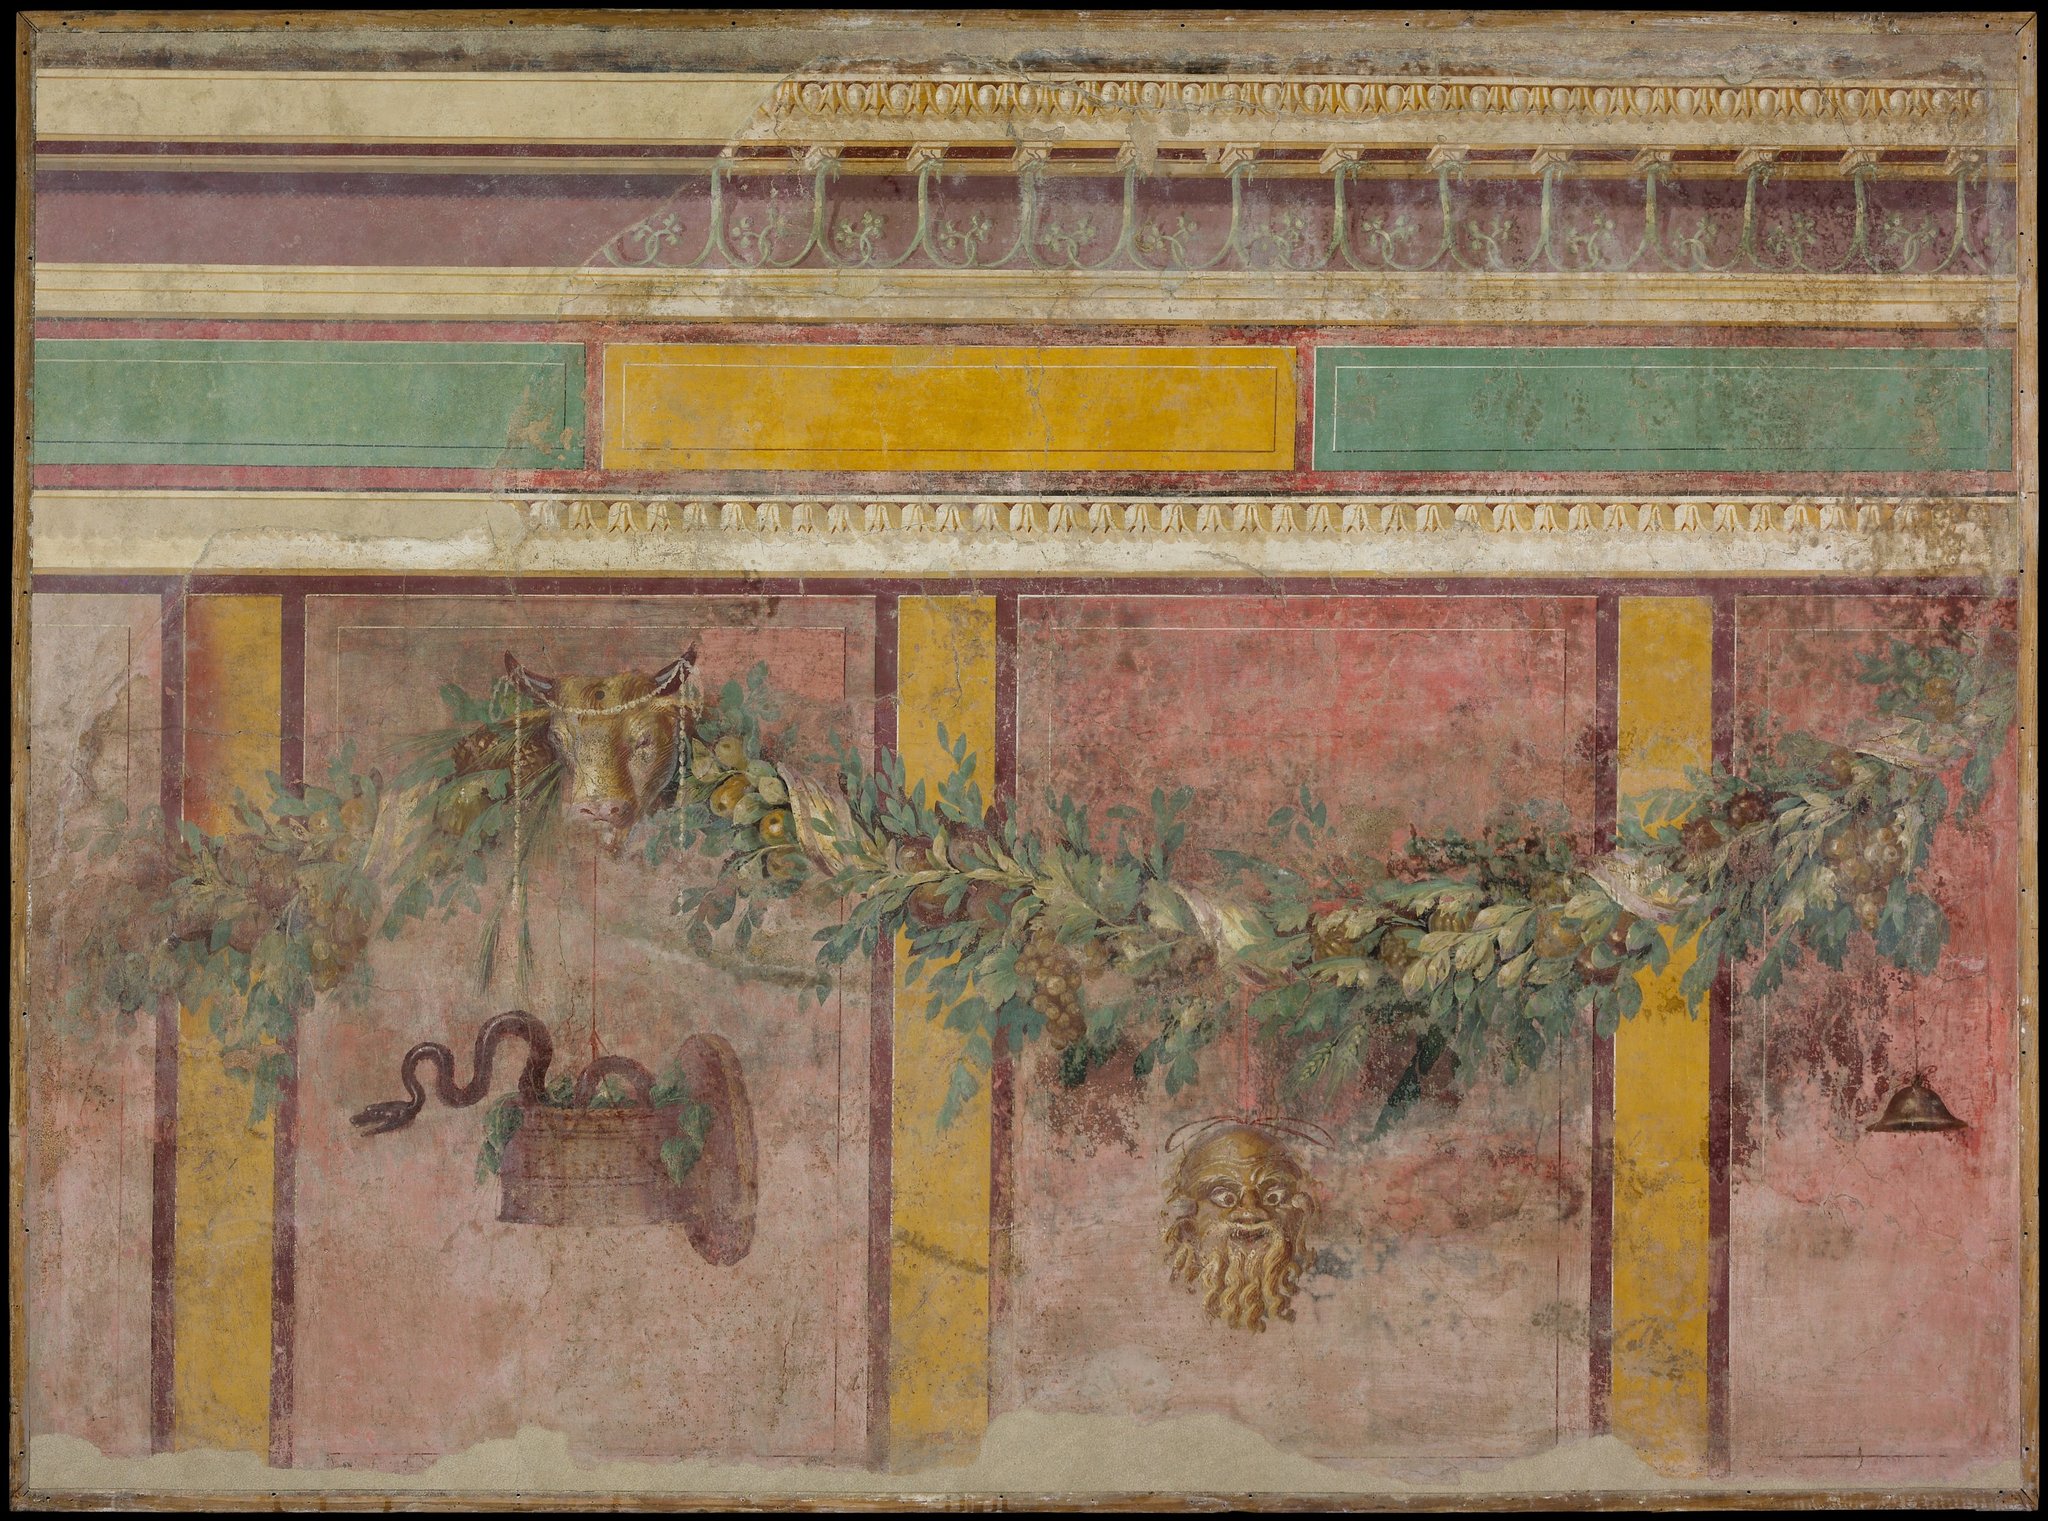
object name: wall painting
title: Wall painting from the west wall of Room L of the Villa of P. Fannius Synistor at Boscoreale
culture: roman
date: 50-40 BCE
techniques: fresco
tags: masks,garlands,fruit,bulls,snakes